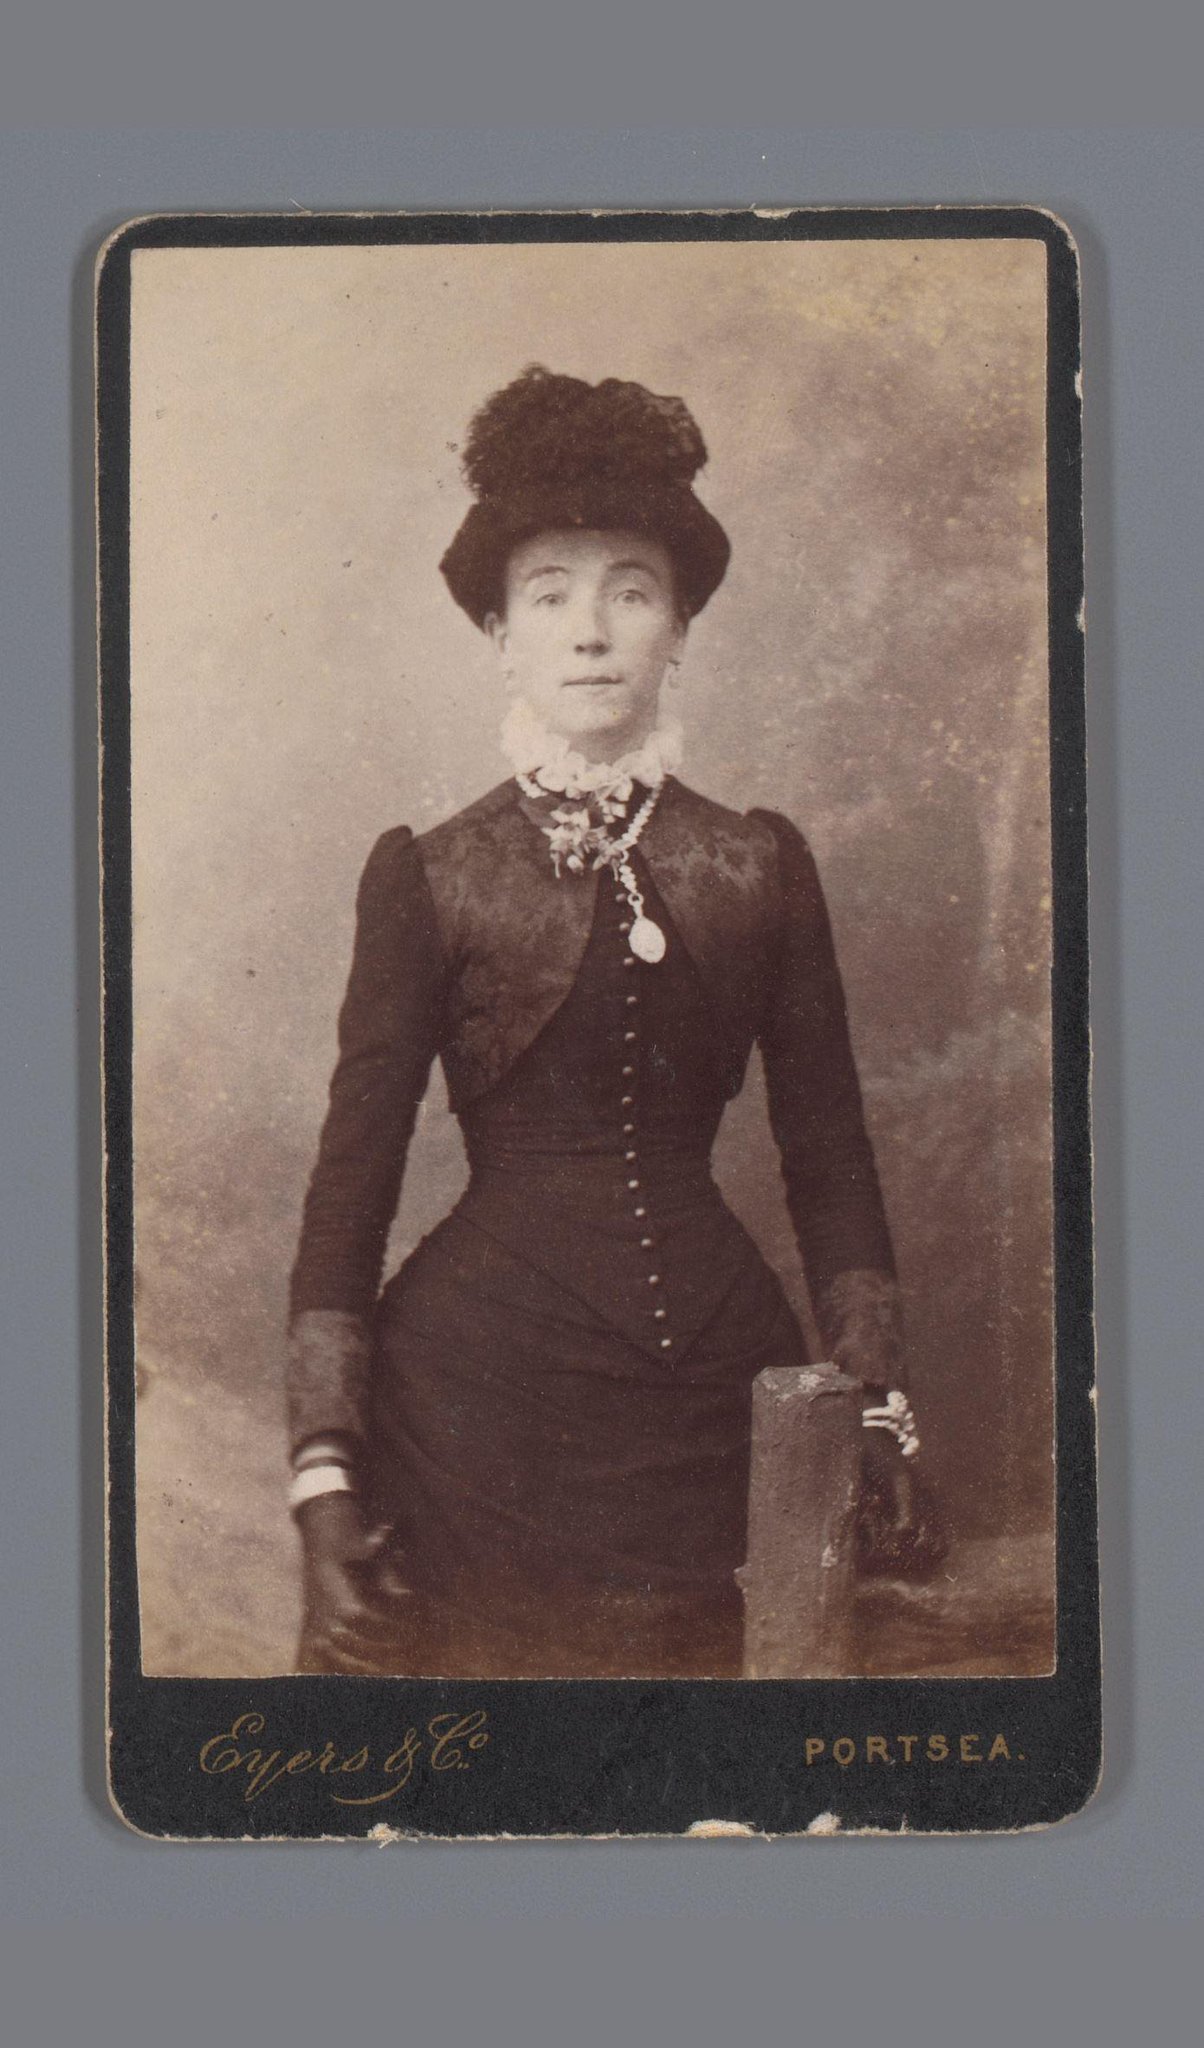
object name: carte de visite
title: Portret van Annie Bull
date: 1808-1885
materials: cardboard, paper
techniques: albumen print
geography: portsmouth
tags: adult woman, historical persons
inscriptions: inscription: ‘PHOTOGRAPHS/ COLOURED & ENLARGED./ IN THE BEST STYLE OF ART./ COPIES OF THIS PHOTOGRAPH CAN ALWAYS BE HAD/ OR ENLARGED UP TO LIFE SIZE.’, inscription: ‘Annie Bull/ August 1885’, inscription: ‘8,85’